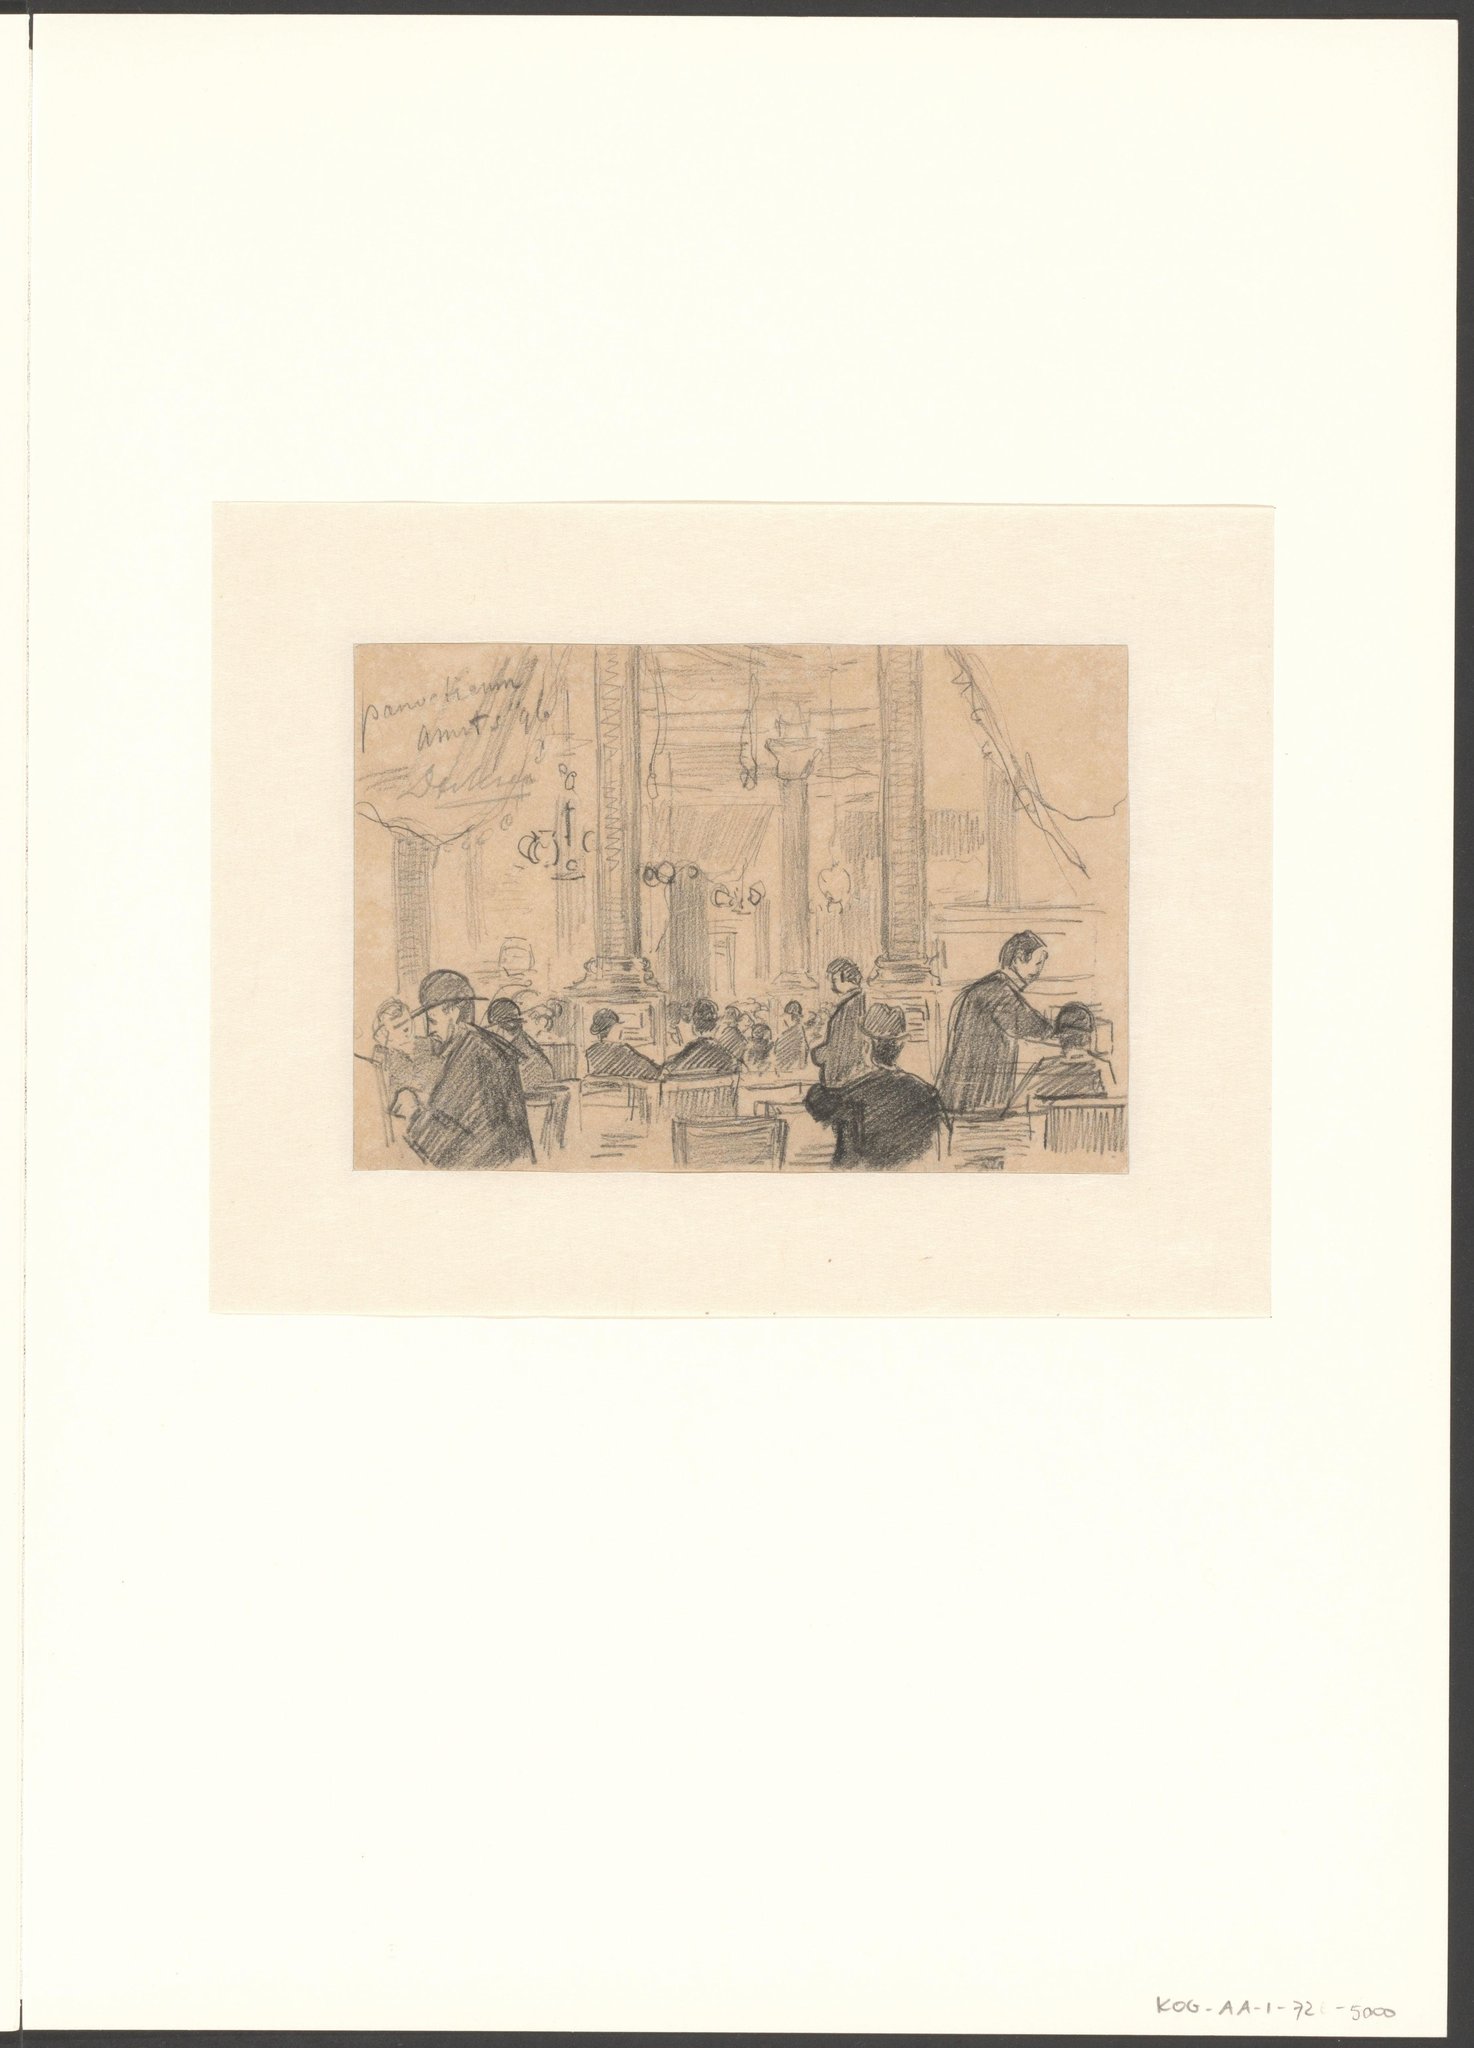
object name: drawing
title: Interieur van een kamer in het Nederlandsch Panopticum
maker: antoon derkzen van angeren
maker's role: draughtsman, print maker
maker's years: 1878-1961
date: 1896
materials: chalk, paper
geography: amsterdam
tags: wax-figure cabinet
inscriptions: signature, date and inscription: ‘panopticum / Amts 3'96 / Derkzen’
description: Onderwerpsrubriek binnen de Atlas Amsterdam: Panopticum. Interieur van het café-restaurant van het Nederlandsch Panopticum, Amstelstraat 16-18.